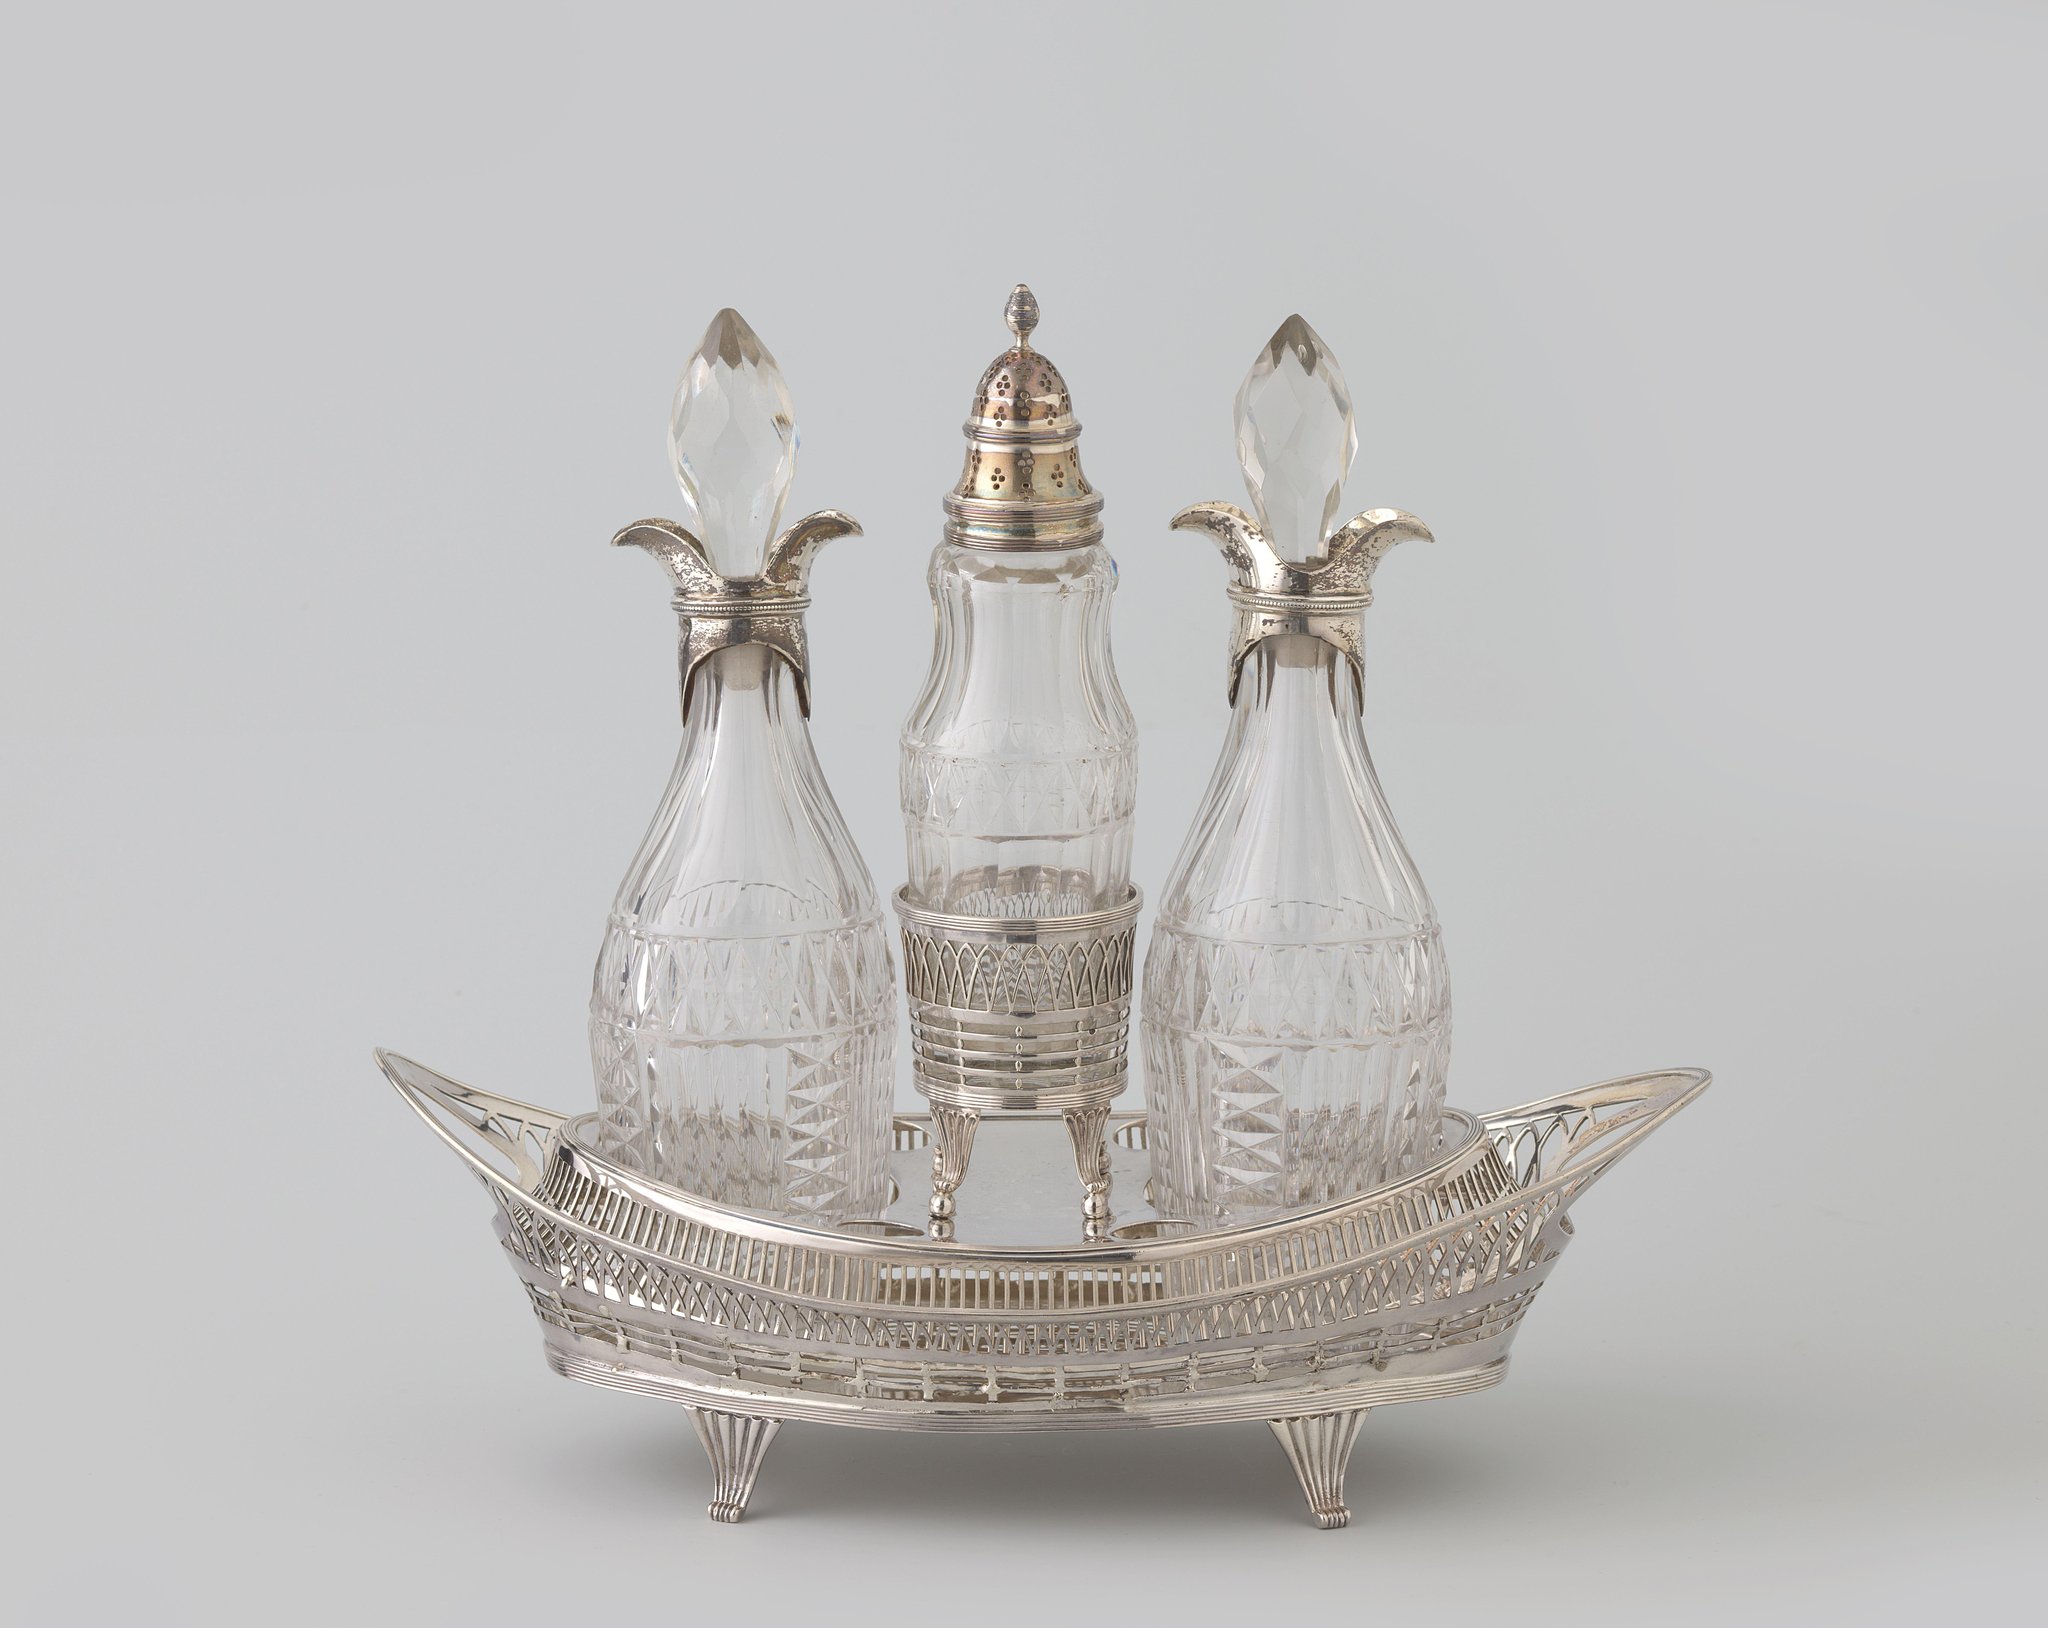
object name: cruet set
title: Olie- en azijnstel met twee flessen en een strooibus in spitsovale houder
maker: hendrik smits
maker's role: silversmith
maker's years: 1772-1841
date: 1803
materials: glass, silver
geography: amsterdam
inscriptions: town mark, date letter: ‘U’, retailer's mark: ‘DIEMONT’, alloy mark, maker's mark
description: De spits ovale houder van het olie- en azijnstel heeft een gewelfde, aan de zijkanten iets verhoogde wand. Hij rust op vier zich naar beneden toe verjongende, gebogen, geribde pootjes. Boven deze pootjes en langs de bovenzijde van de houder lopen filetranden. De wand is opengewerkt met een patroon van (gedeeltelijk beschadigde) liggende tralies tussen twee gladde banden, waarboven een patroon van spitsbogen. In de korte zijden zijn afgerond driehoekige oren uitgespaard. In de houder bevindt zich een ovaal inzetstuk met een gewelfde, aan de korte zijden iets verhoogde wand. Deze is opengewerkt met een patroon van staande tralies. In de bovenzijde bevinden zich twee grote en vier kleine ronde openingen. In de grote openingen passen twee gelijke, in diverse slijpwerk versierde flessen van kleurloos glas, bestemd voor olie en azijn. Het bovenste gedeelte van elke fles is gevat in een zilveren montuur die versierd is met een parelrand tussen profielranden. Aan de onderzijde eindigt de montuur voor en achter in een punt, aan de bovenzijde voor en achter in een snebvormige tuit. De flessen hebben een druppelvormige, in facetpatroon geslepen stop. De stoppen kunnen in de kleine openingen van het inzetstuk worden gehangen. Middenop het inzetstuk is een cilindervormige houder geschroefd, waarvan de op bolletjes geplaatste pootjes en de versiering van zaagwerk en filetranden een herhaling zijn van die van de grote houder. In de houder past een in divers slijpwerk versierde, glazen peperstrooier. Deze heeft een meervoudig gewelfde, door twee filet- en een profielrand gelede, zilveren dop, die is opengewerkt met een patroon van puntjes, en wordt bekroond door een pijnappelvormige, geribde knop.